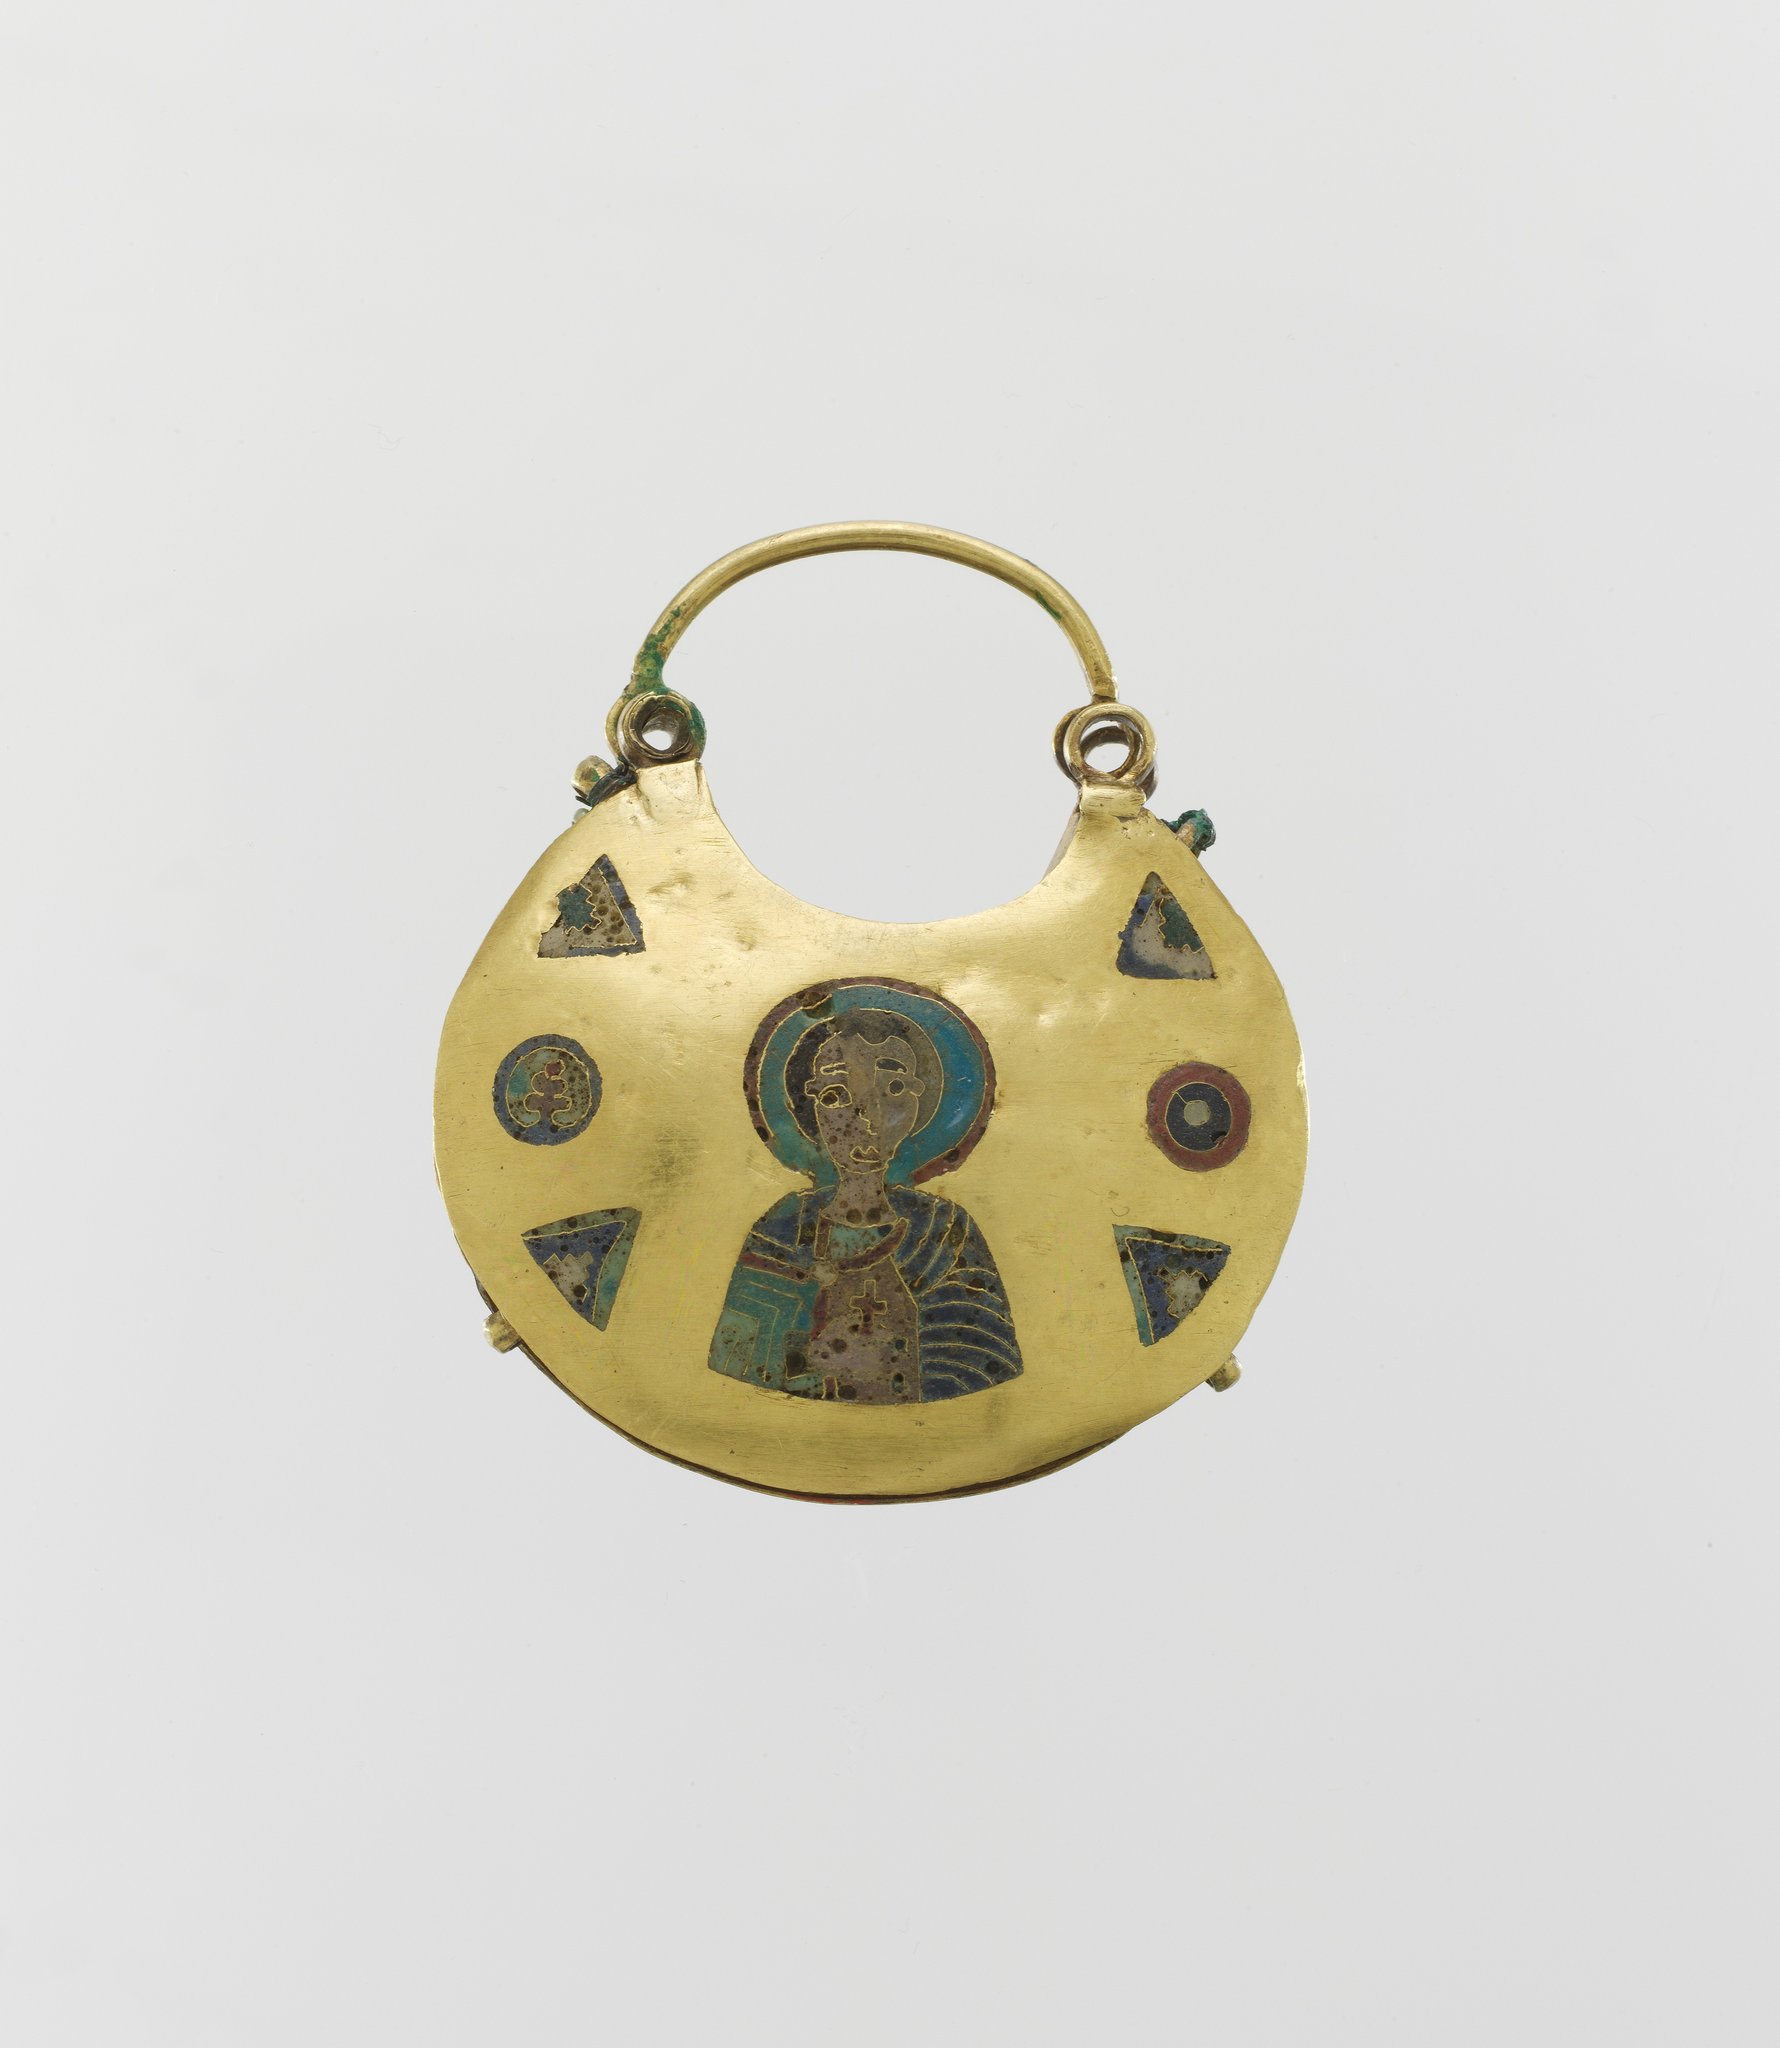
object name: temple pendant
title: One of a Pair of Temple Pendants, with Busts of Male Saints Holding Martyr's Cross (front) and Leaf and Rosette Motifs (back)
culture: kyivan rus’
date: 1001-1200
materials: enamel, gold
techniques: enamel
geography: ukraine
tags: men,saints